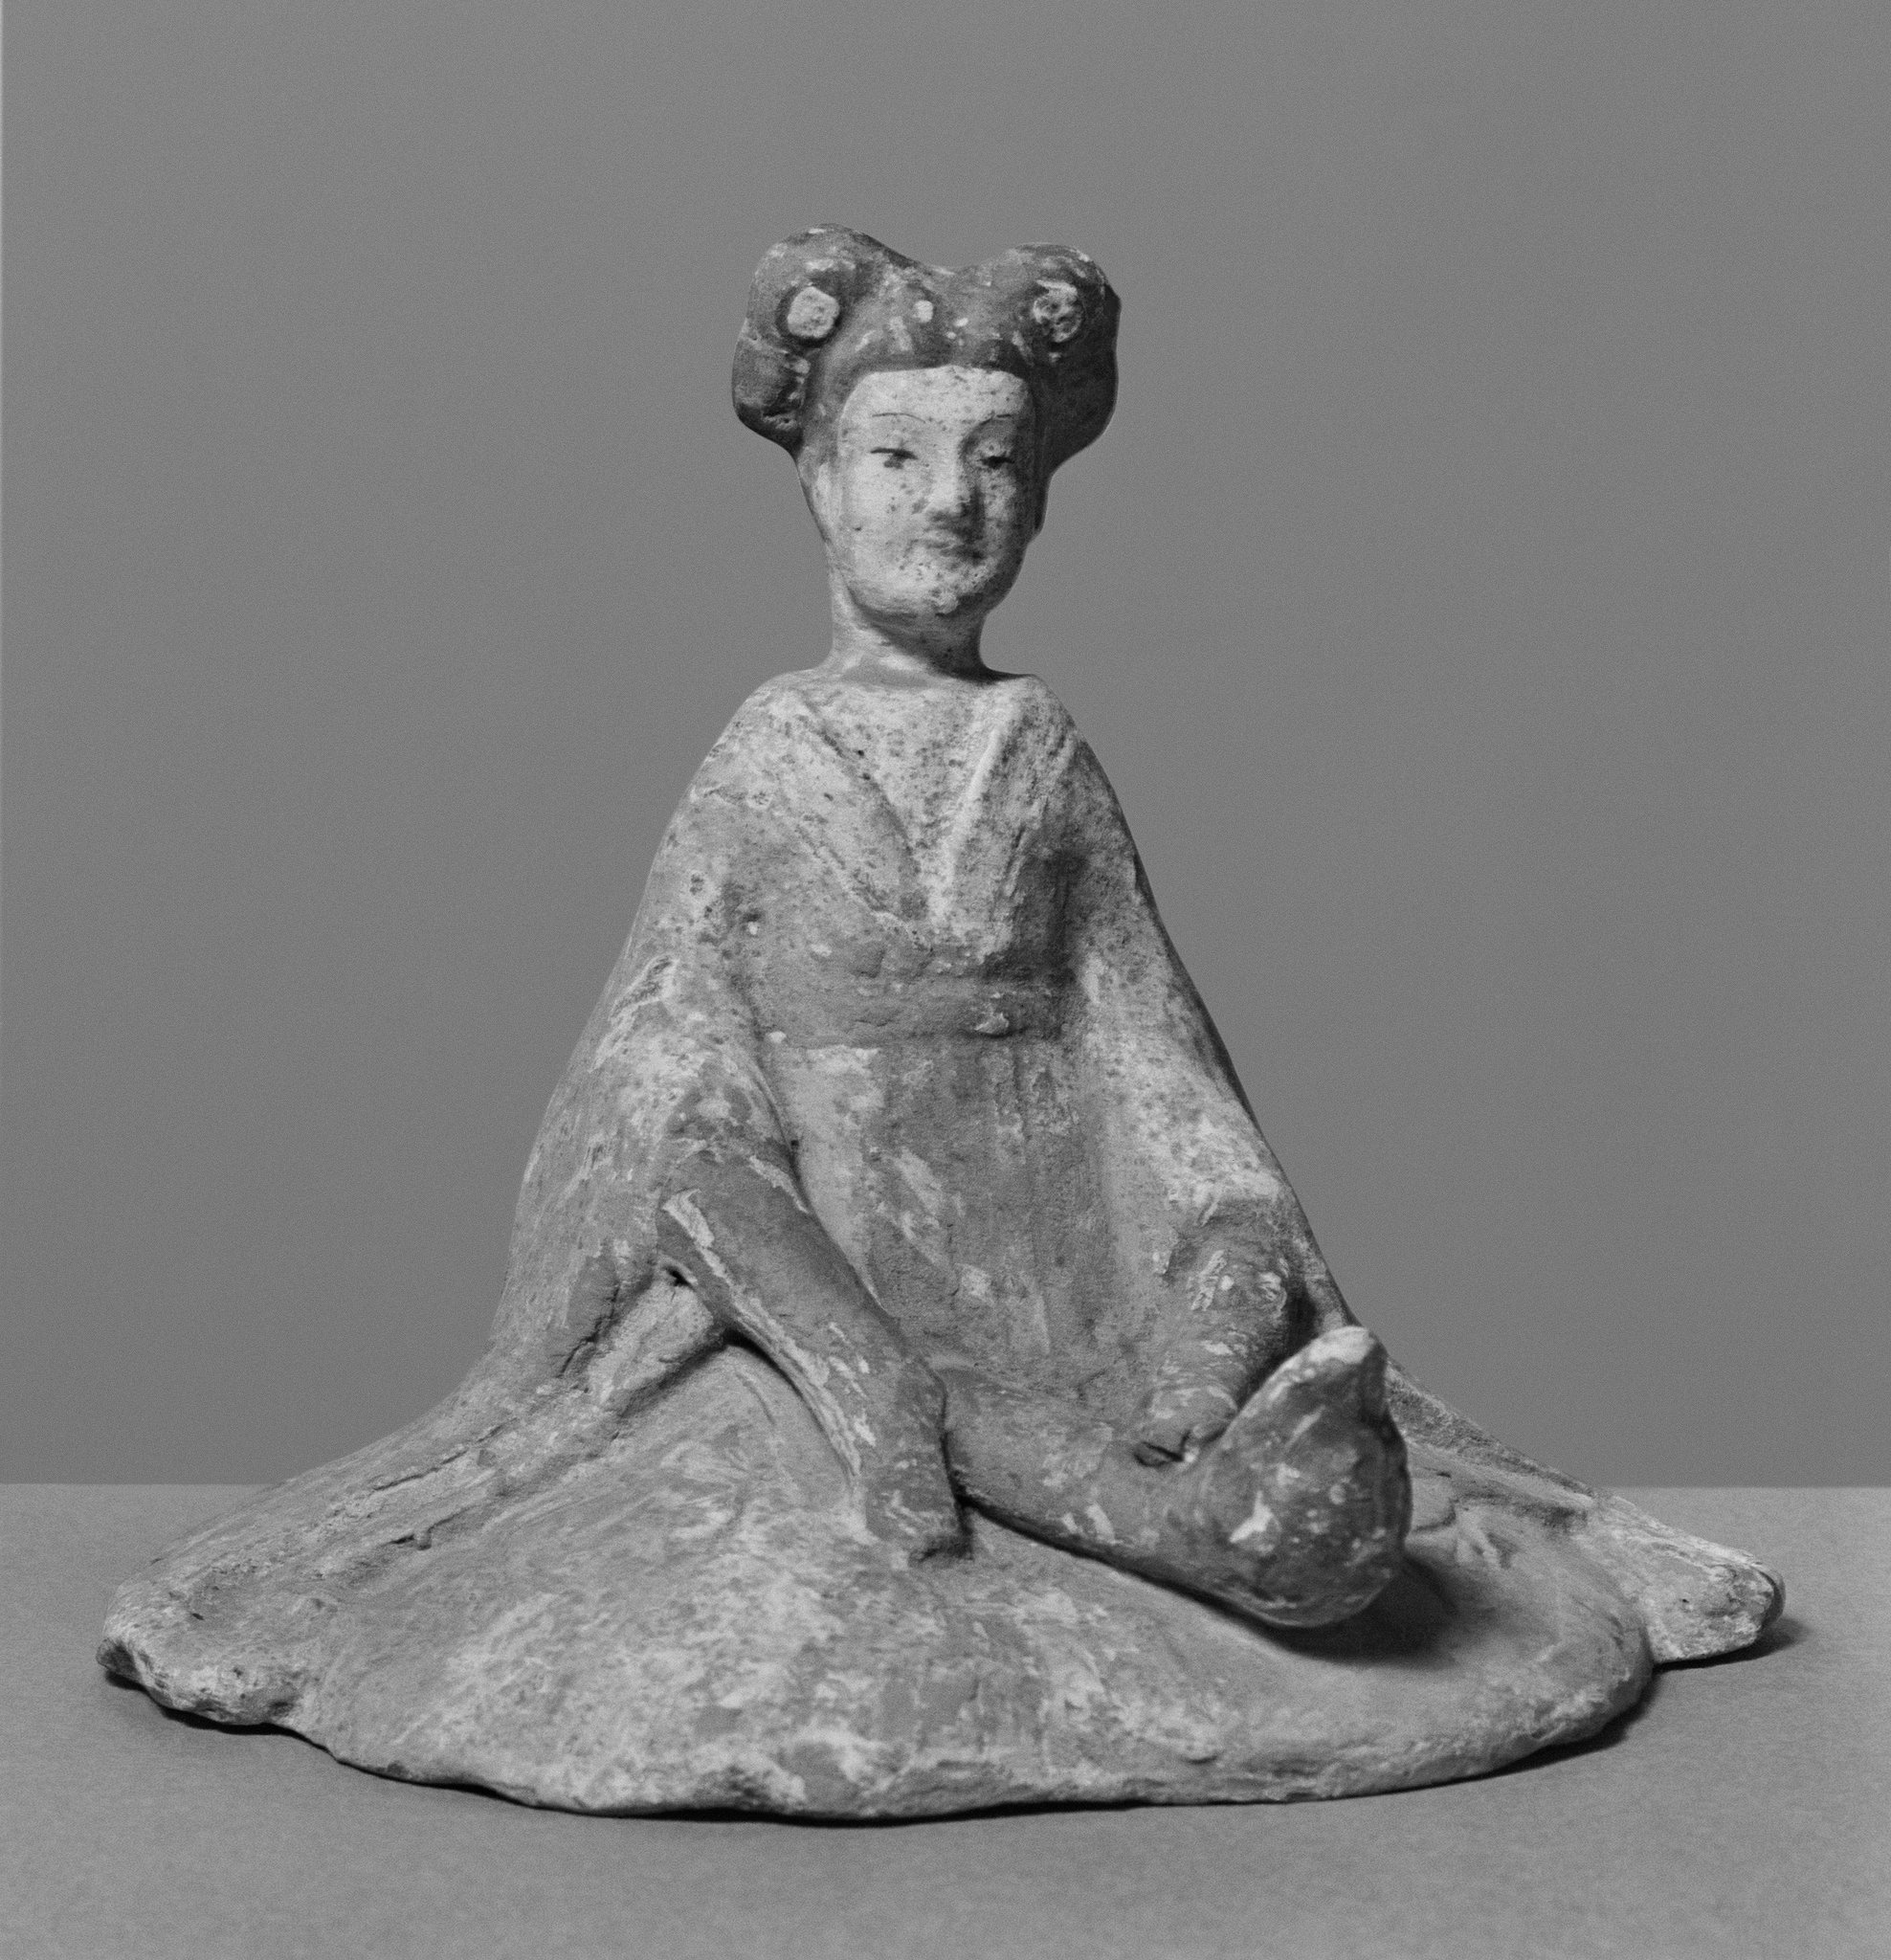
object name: figure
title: Female musician with harp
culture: chinese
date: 501-700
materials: earthenware, pigment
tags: women